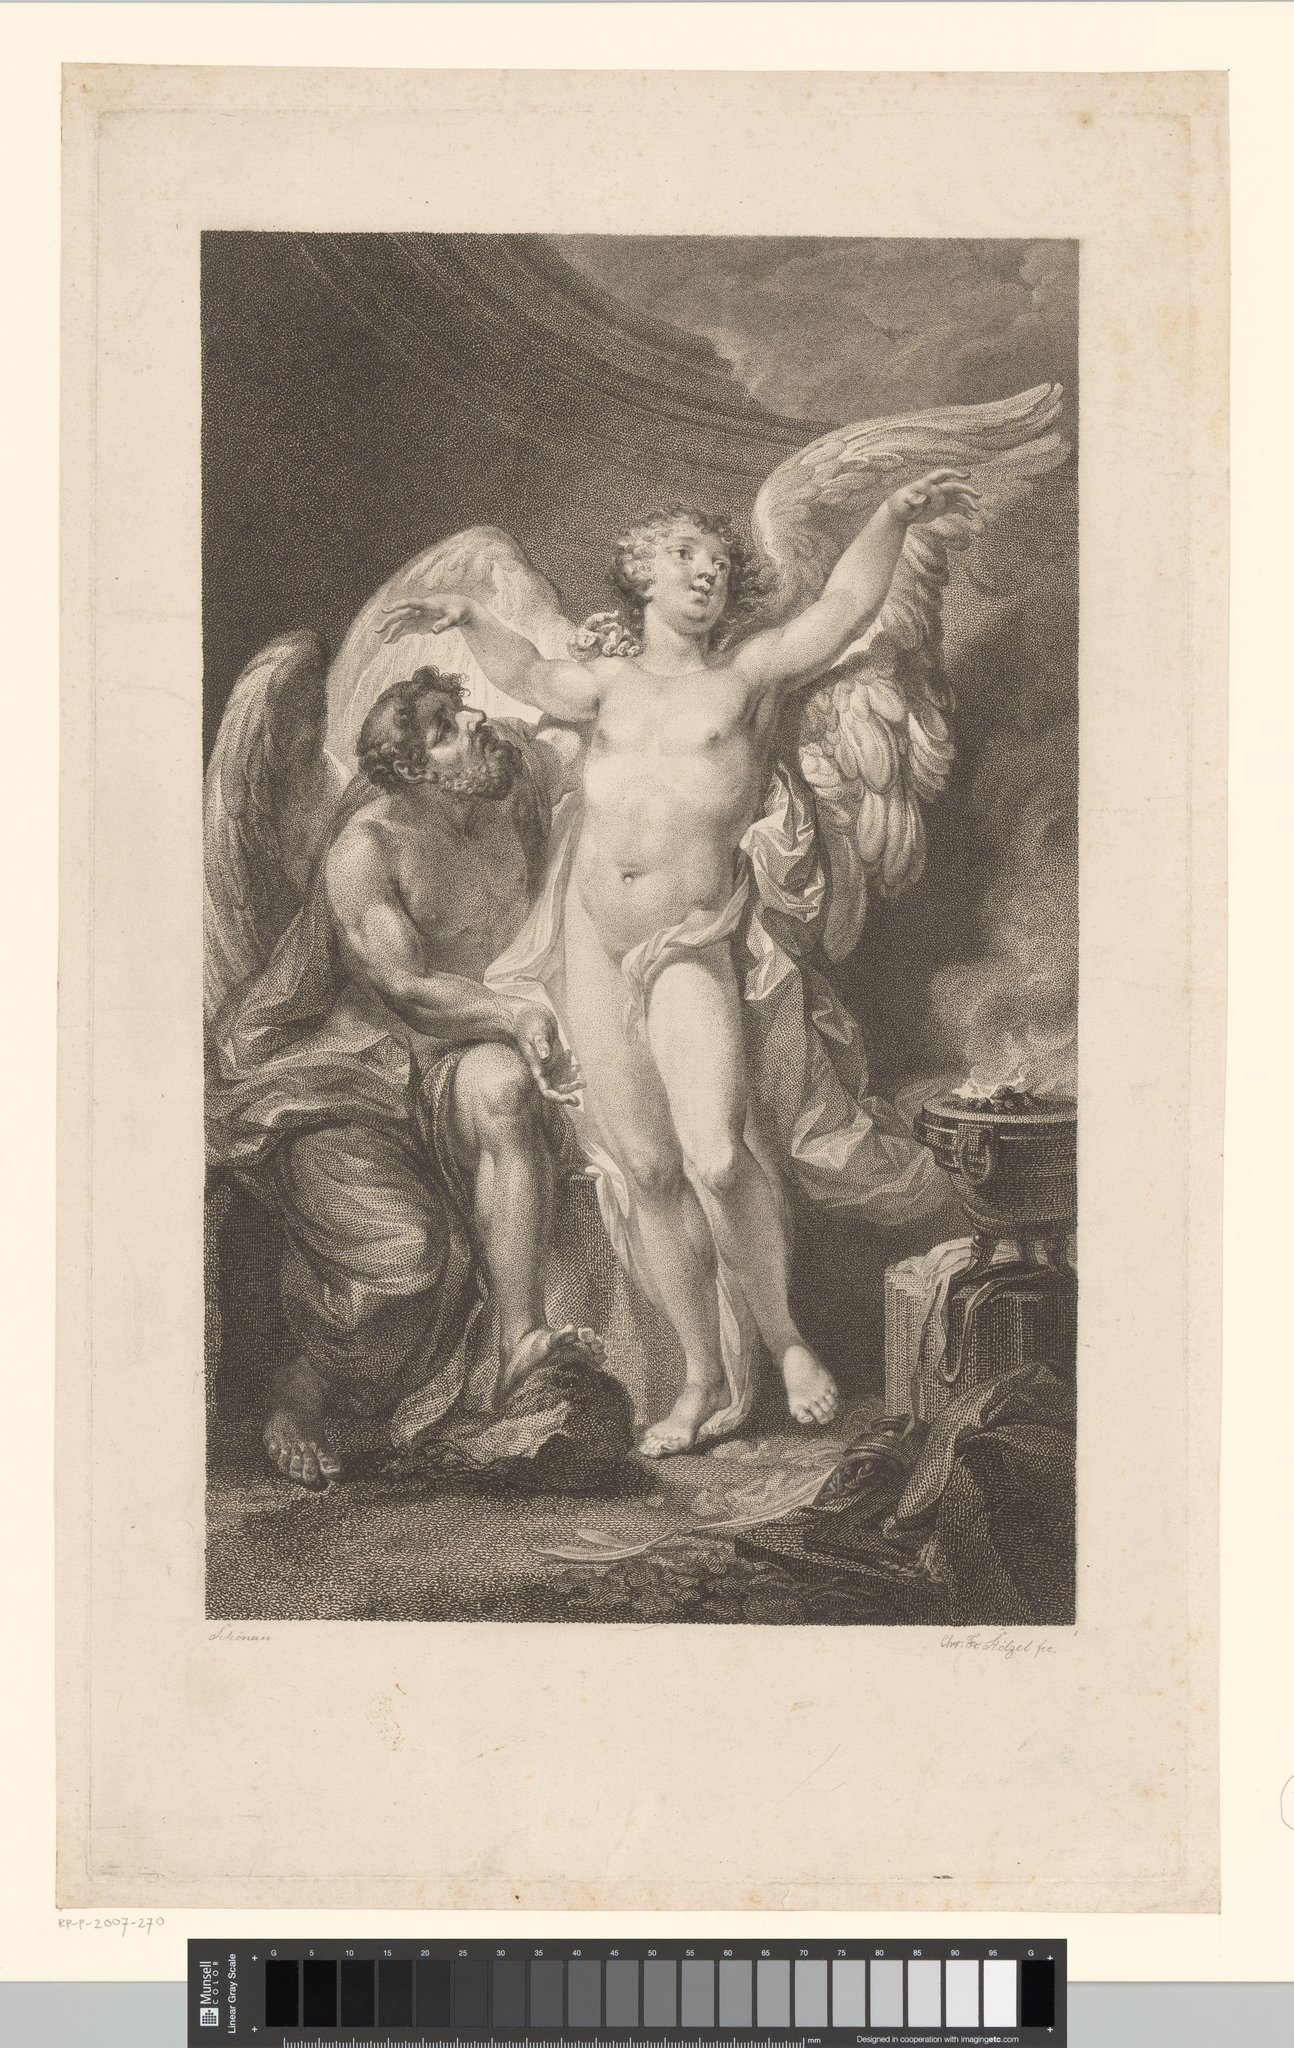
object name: print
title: Daedalus leert Icarus hoe te vliegen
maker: christian friedrich stölzel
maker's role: draughtsman, print maker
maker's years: 1751-1816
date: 1761-1816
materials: paper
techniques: etching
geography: dresden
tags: daedalus fixes the wings on icarus and on himself, and teaches his son how to fly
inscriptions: inscription: ‘Chr. Fr. Stölzel fec.’, inscription: ‘Schönau’, collector's mark: Lugt 2228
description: Daedalus heeft zijn zoon Icarus zijn vleugels aangezet en leert hem hoe te vliegen. Icarus staat met de armen gespreid. Rechts een vuurpot.